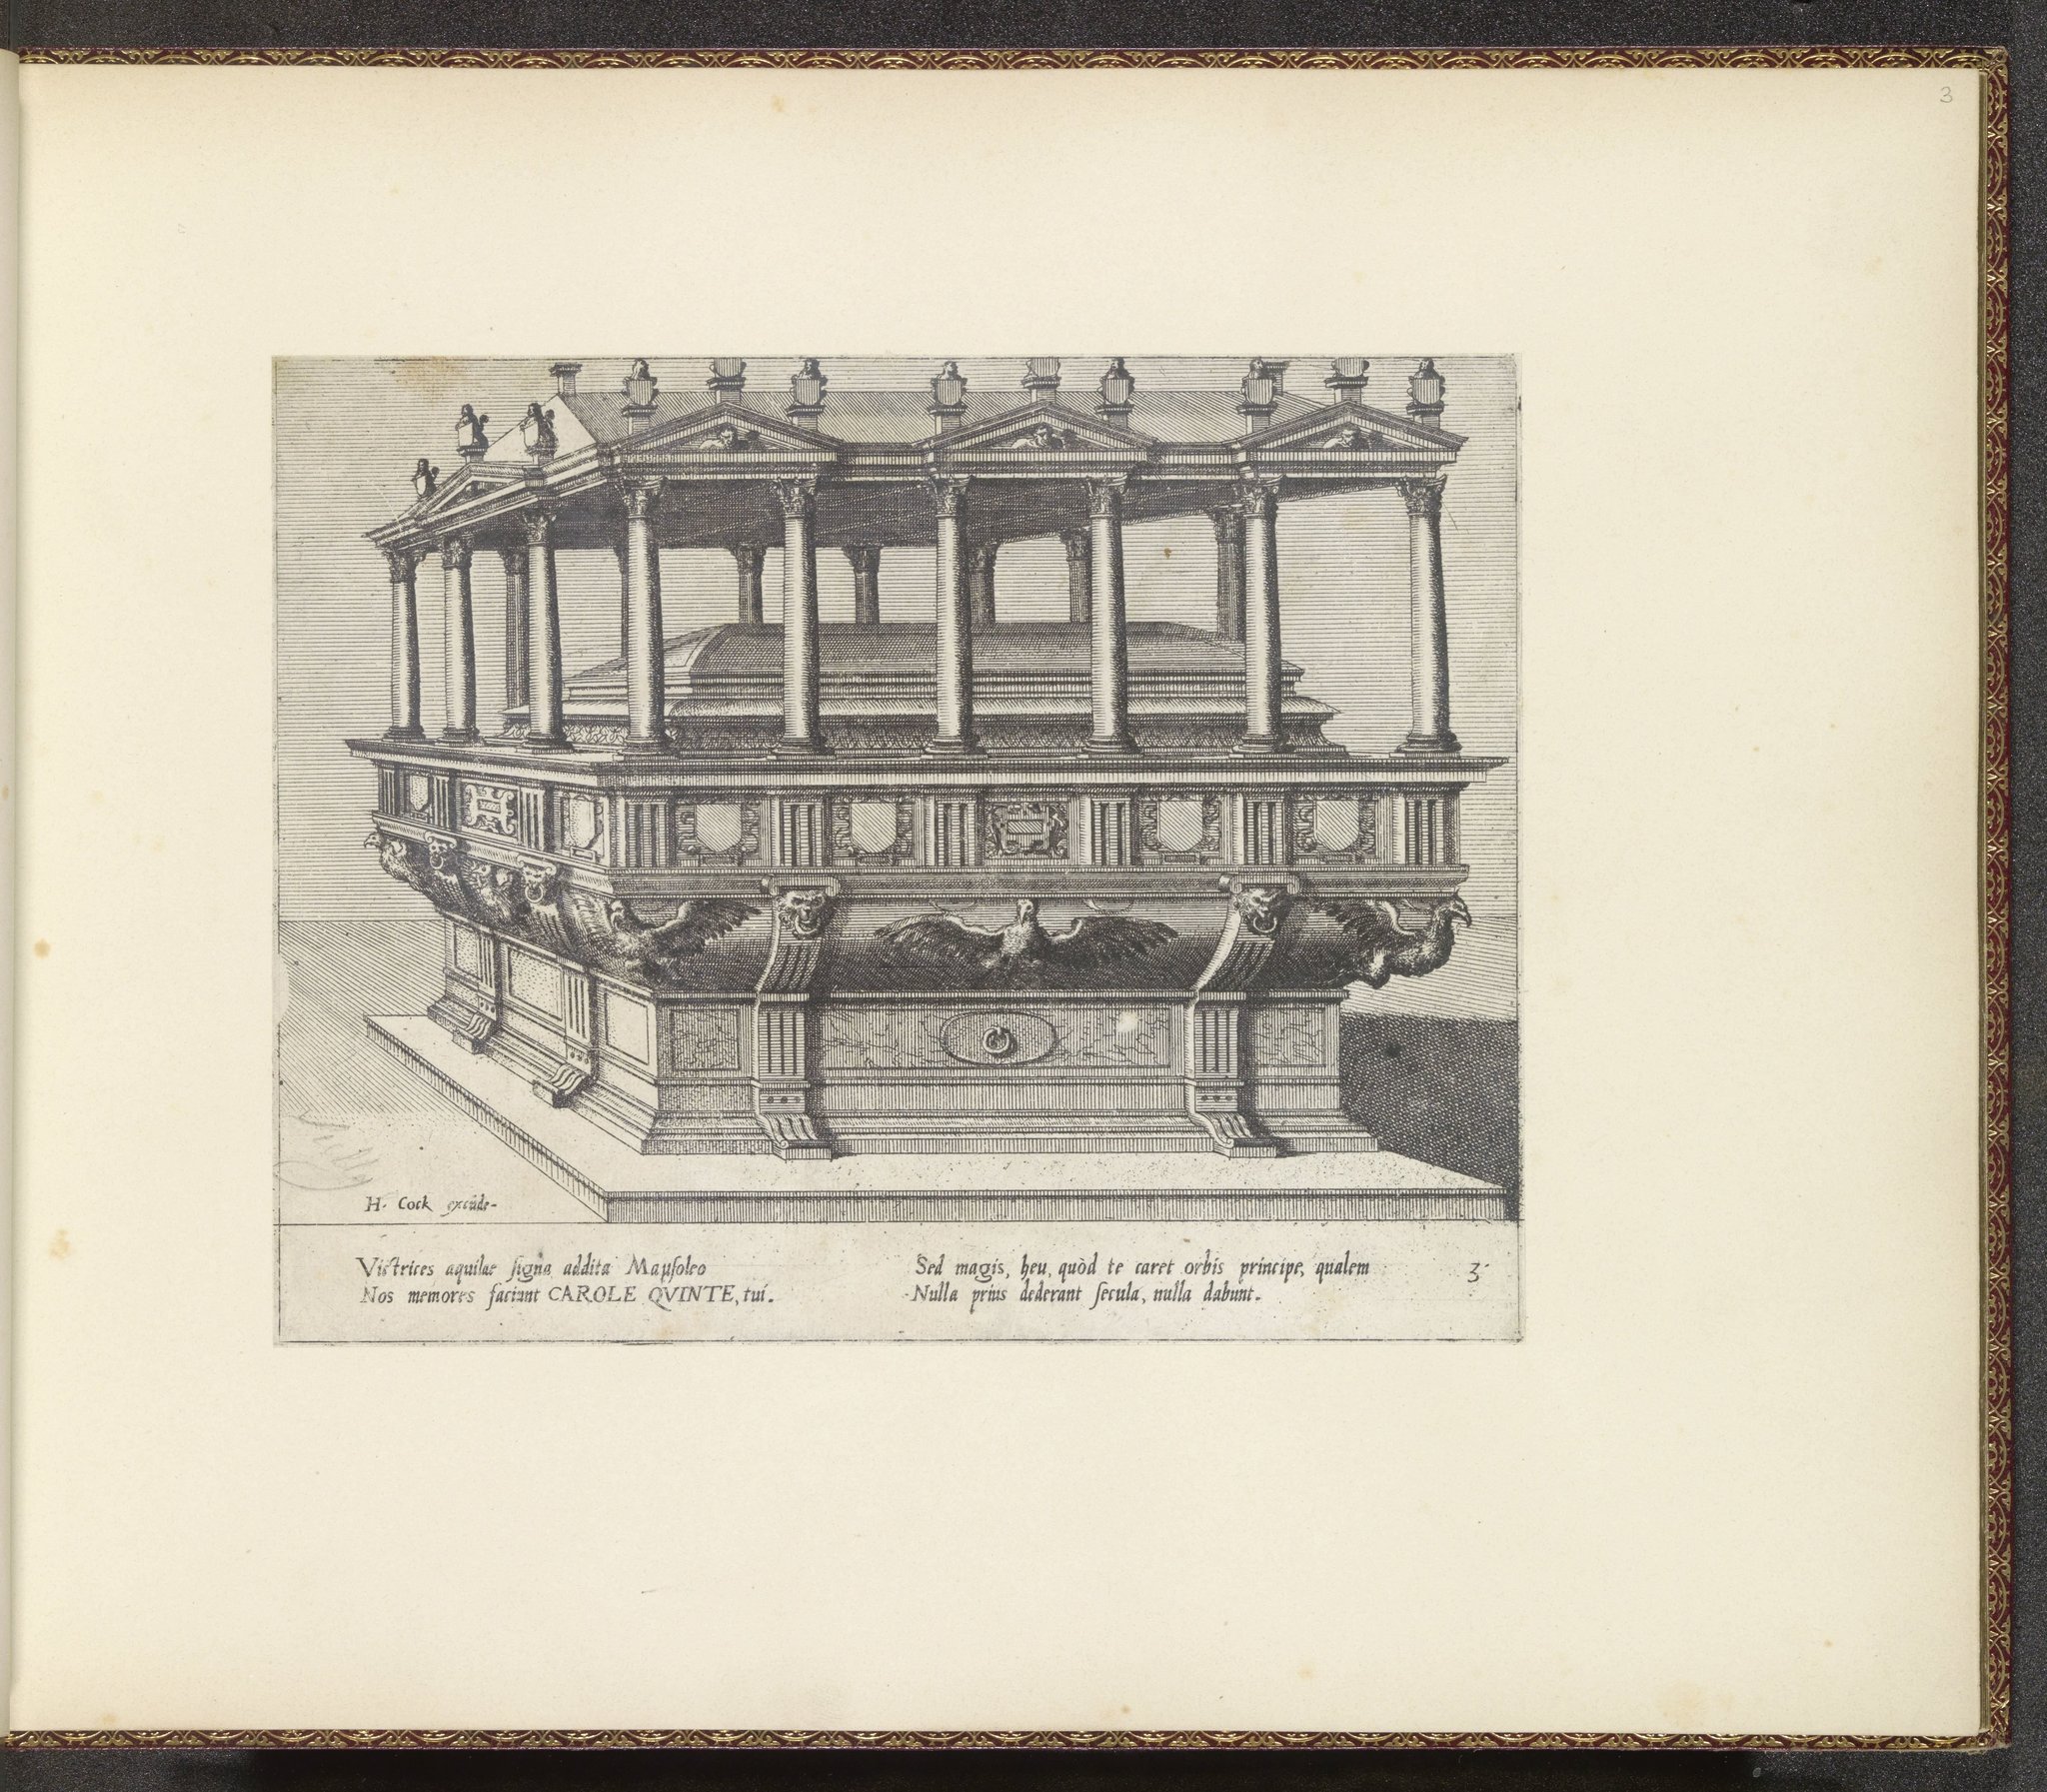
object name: ornament print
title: Coenotaphiorum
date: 1563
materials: paper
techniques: etching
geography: antwerp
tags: predatory birds: eagle, grave-building, monumental tomb, grave, tomb and other grave-forms and grave-markers, corinthian order ~ architecture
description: Vrijstaand grafmonument met adelaars en een fries met trigliefen en blanke wapenschilden in de metopen. De overkapping van de sarcofaag met acht frontons wordt ondersteund door Korinthische zuilen. In de ondermarge vier regels tekst, in twee kolommen, in het Latijn. De prent maakt deel uit van een album.